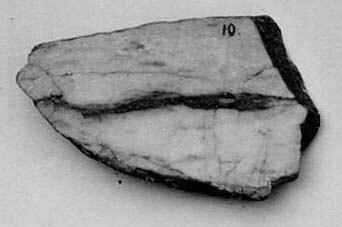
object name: fragment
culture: burmese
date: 1902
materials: jade